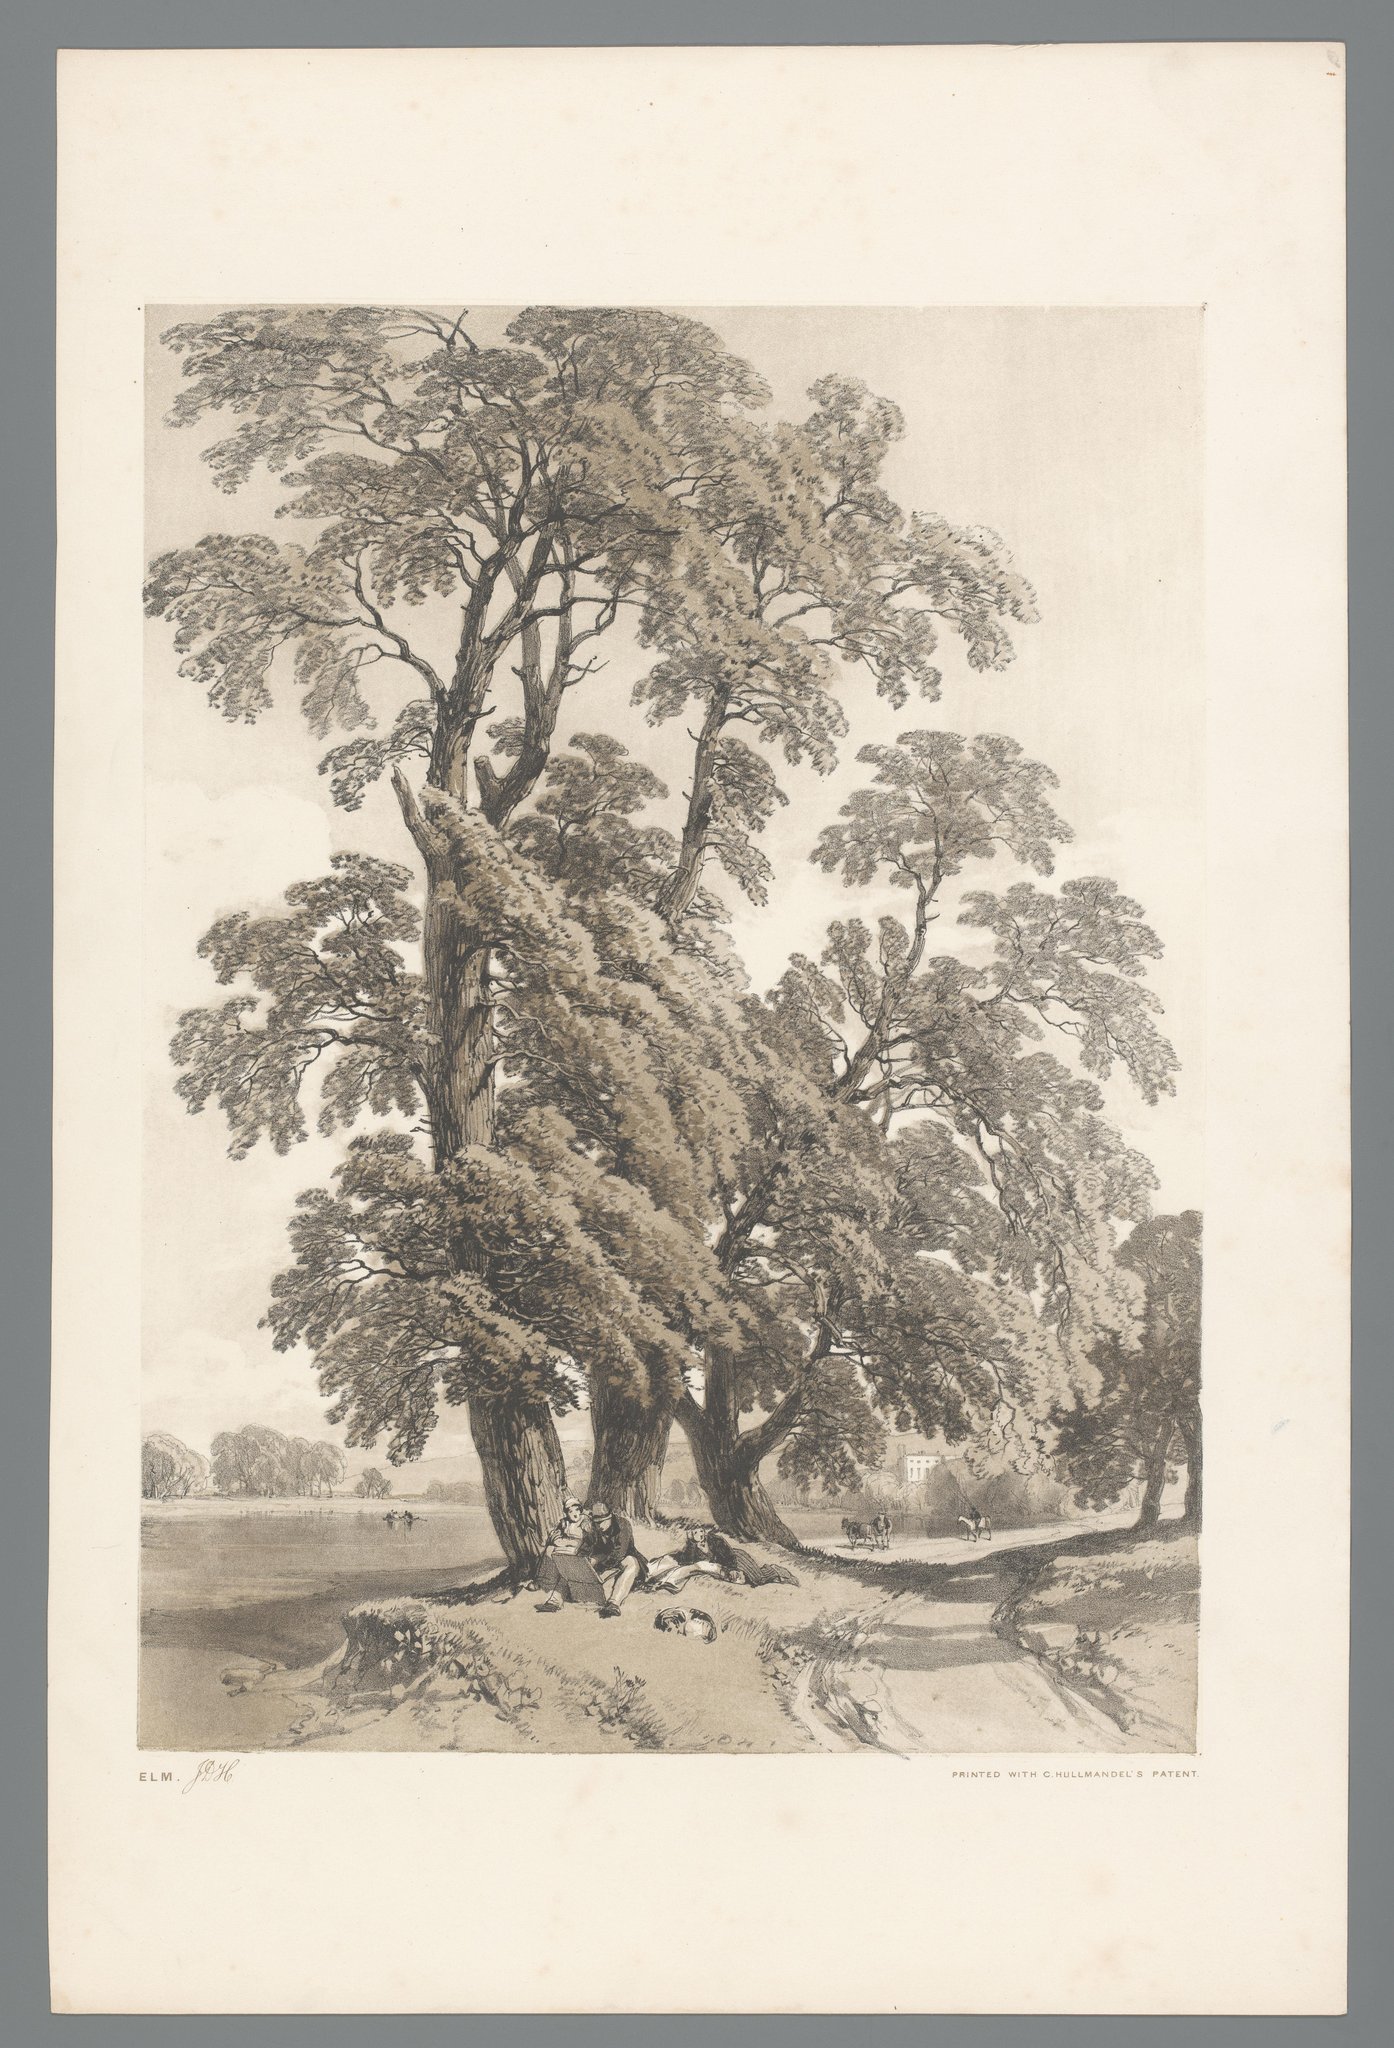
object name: print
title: Elm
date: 1841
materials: paper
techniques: tone lithography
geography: london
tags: park, trees, (traveller) resting in the open air, forest, wood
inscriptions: collector's mark: Lugt 2760, collector's mark: Lugt 2228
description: Prent maakt deel uit van een serie van 24 prenten.